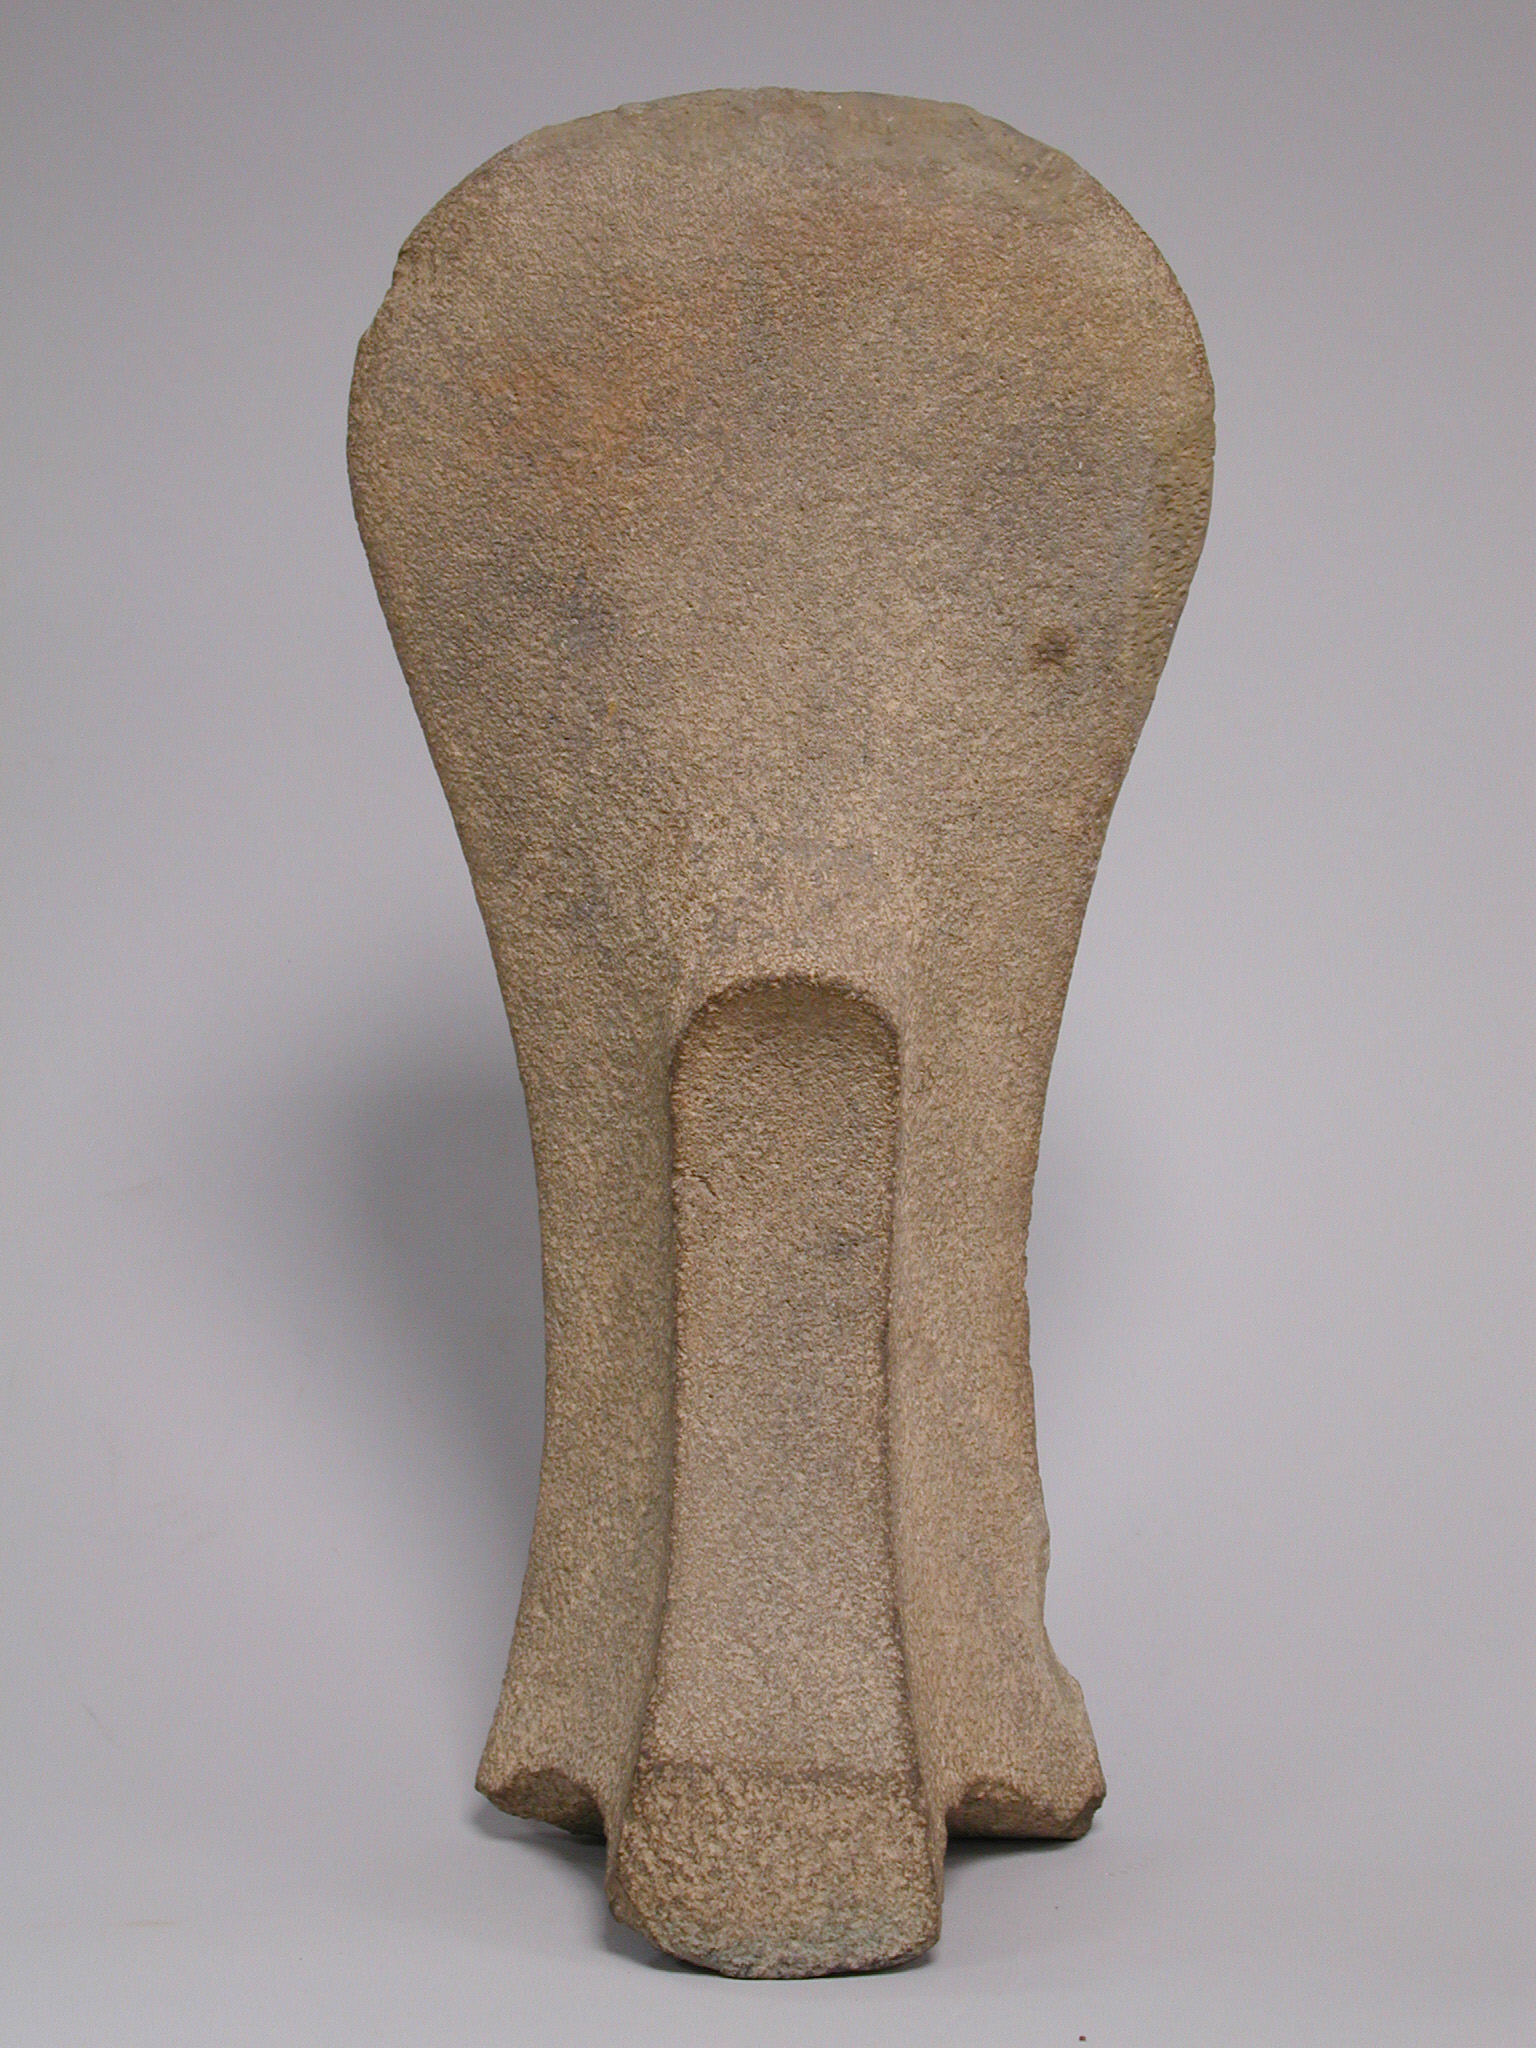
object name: palma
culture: veracruz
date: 601-1000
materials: stone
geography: mexico